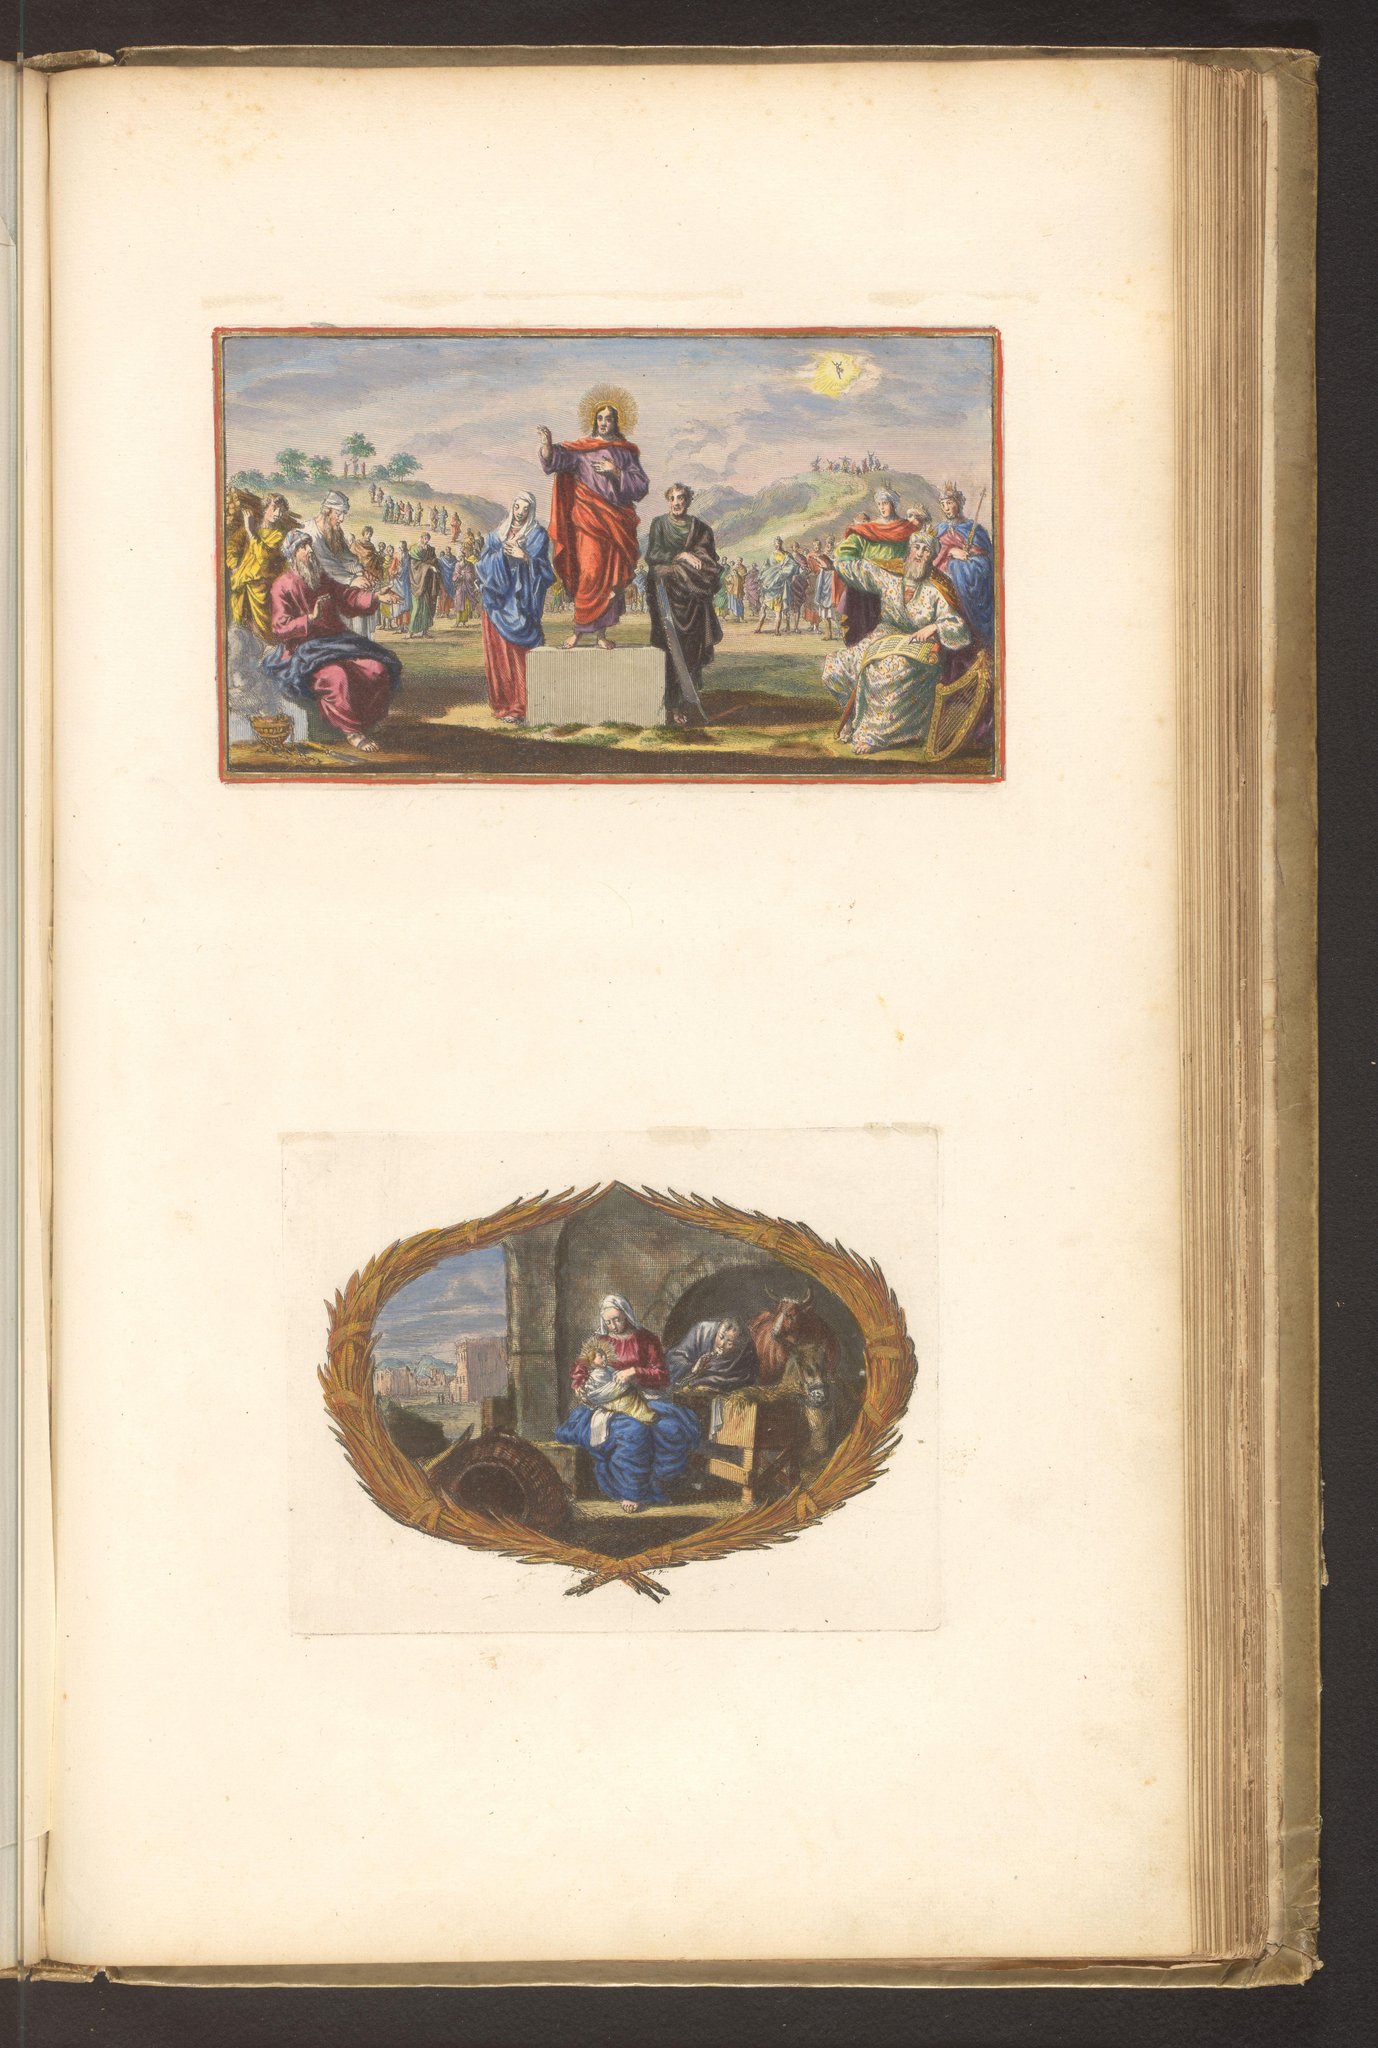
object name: print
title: Blad met illustratie en vignet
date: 1700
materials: paint, paper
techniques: etching, hand coloring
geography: amsterdam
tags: mary, joseph and the new-born christ (nativity)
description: Blad met twee prenten. Boven: Christus staande op een voetstuk. Hij maakt een zegenend gebaar. Links en rechts van hem Jozef en Maria. Links de drie aartsvaderen: Abraham, Isaak en Jakob. Rechts de koningen van Israël, met vooraan koning David. Op de achtergrond links Adam en Eva in het paradijs en rechts de hemelvaart van Christus. Onder: vignet tussen palmtakken met de geboorte van Christus. Blad in het tweede deel van de prentbijbel met het Nieuwe Testament, uitgegeven door Pieter Mortier, Amsterdam 1700.